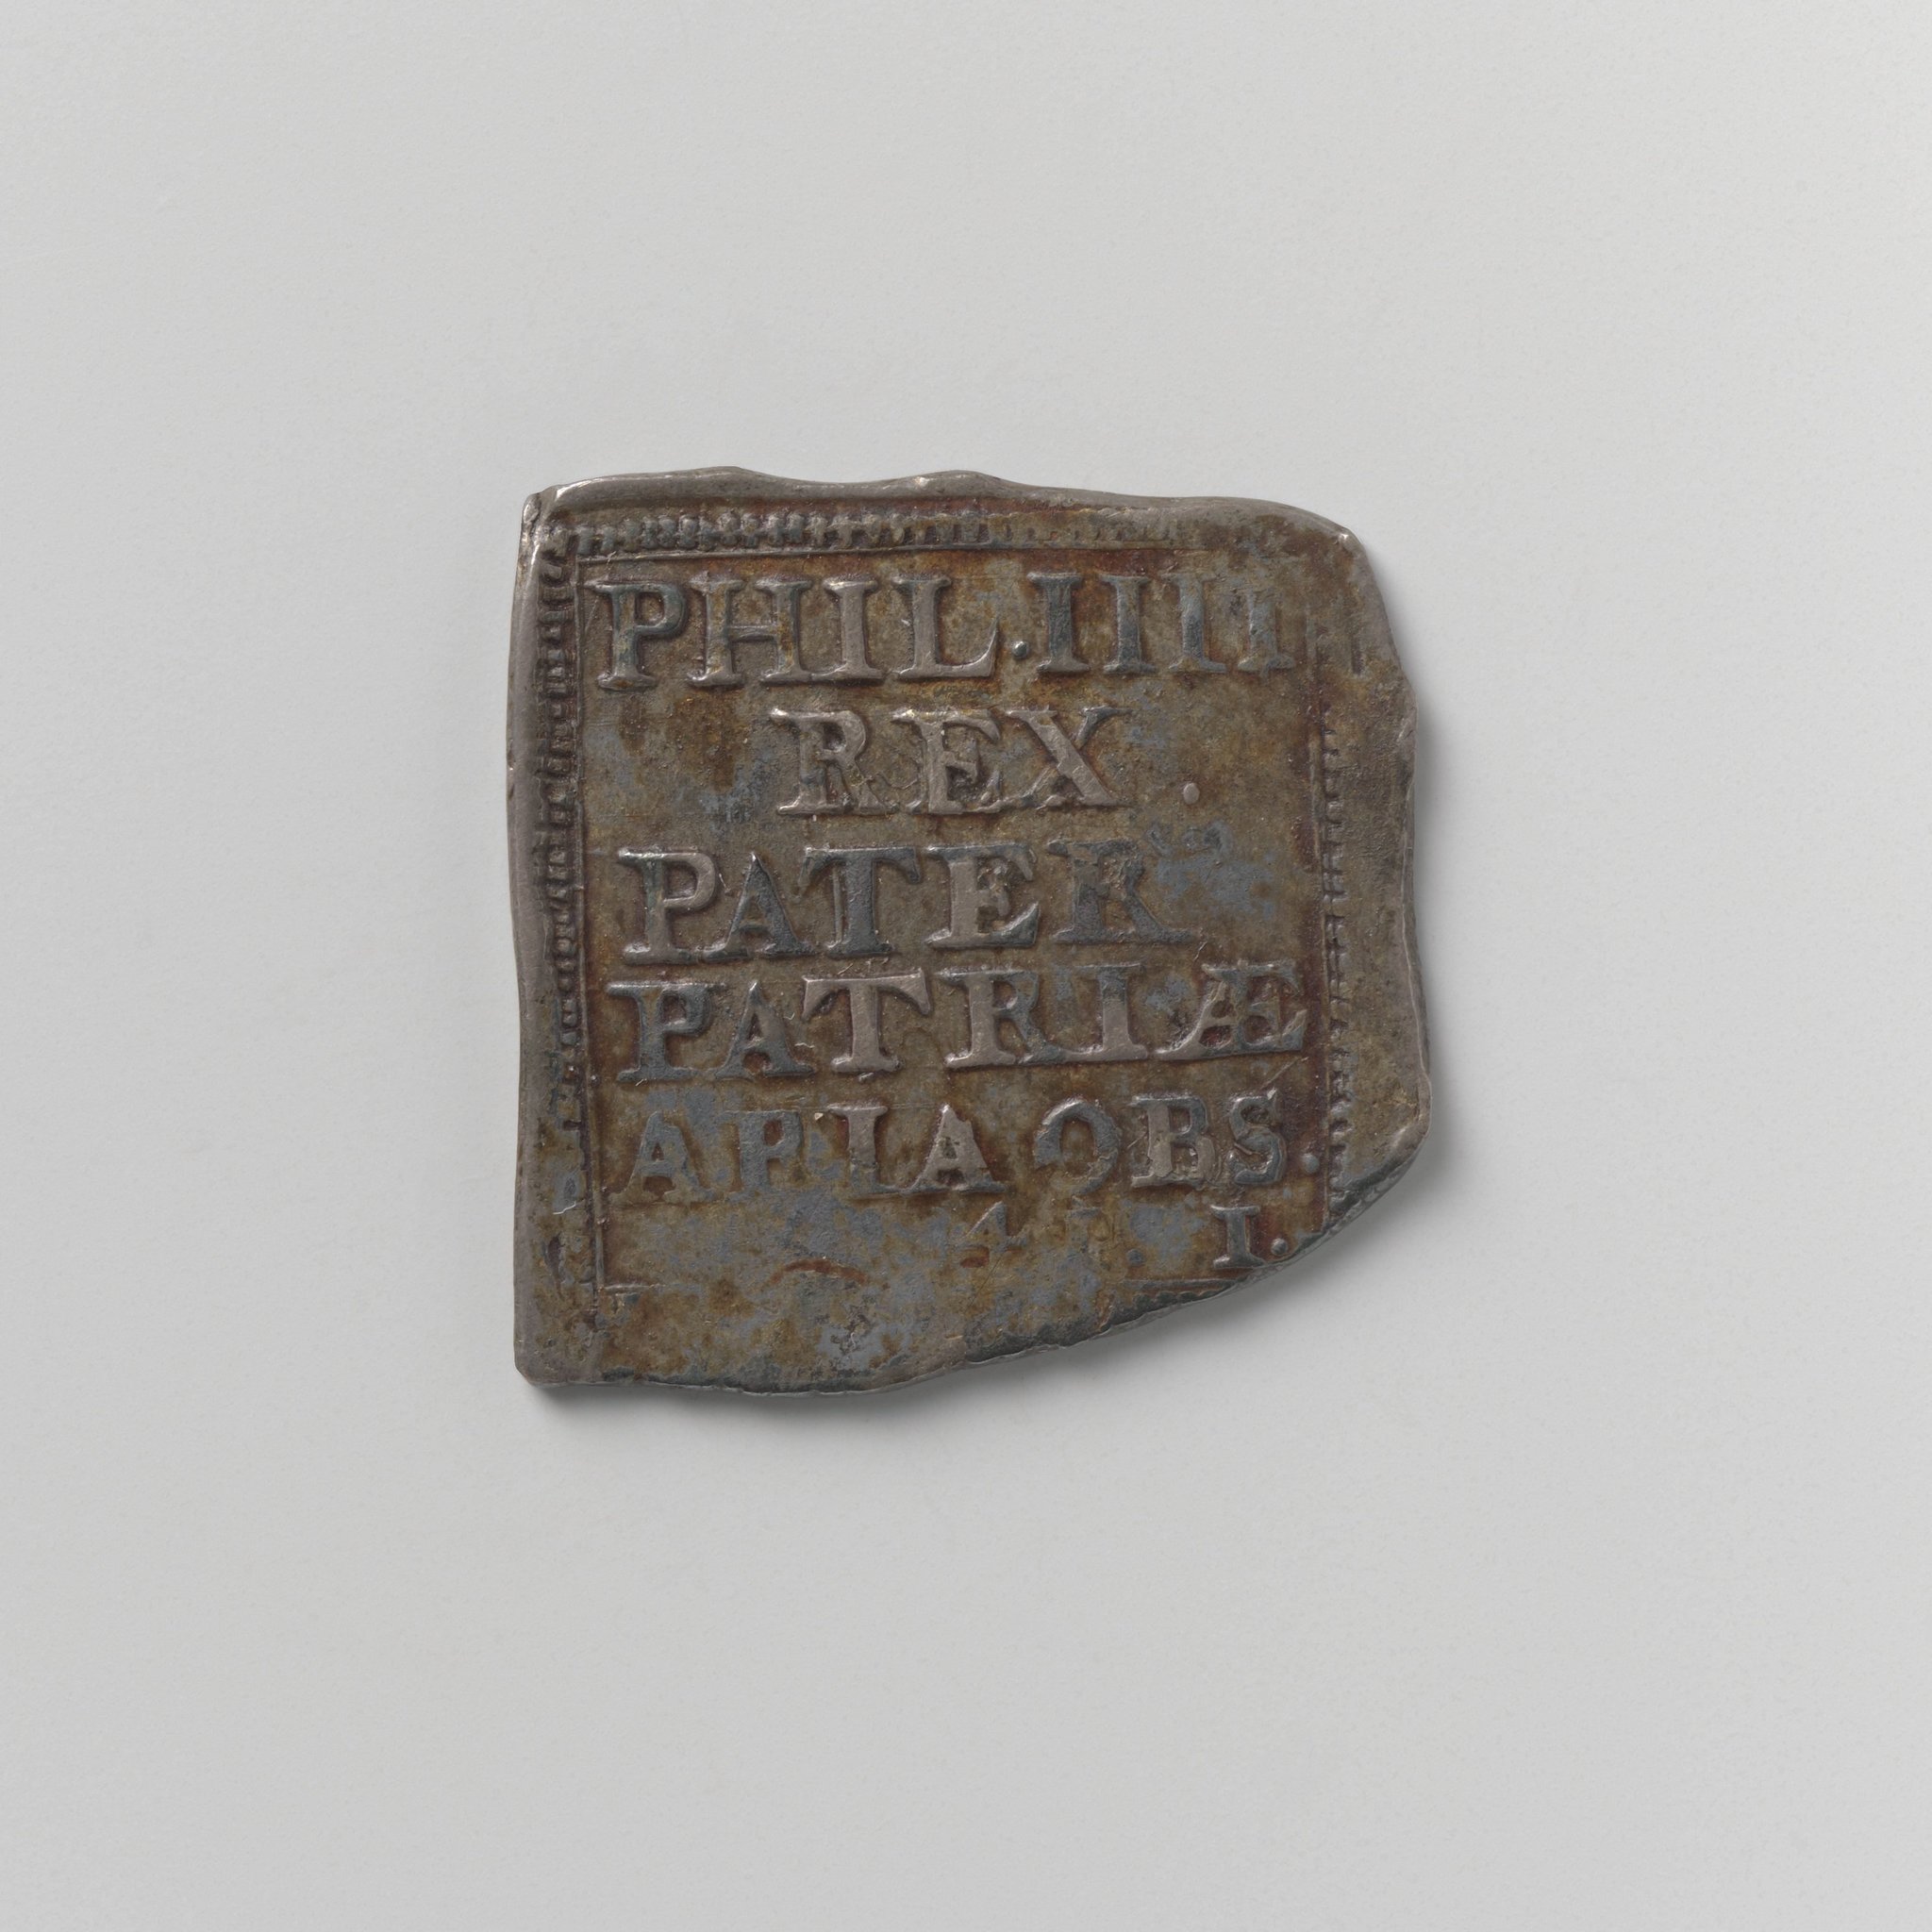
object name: livre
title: livre, noodmunt uit Aire, geslagen tijdens het beleg door de Spanjaarden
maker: Anonymous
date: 1641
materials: silver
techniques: striking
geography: aire-sur-la-lys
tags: filips iv (koning van spanje)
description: Eenzijdige, rechthoekige, zilveren noodmunt van Aire, rechts onder schuin afgeneden. Voorzijde: opschrift.